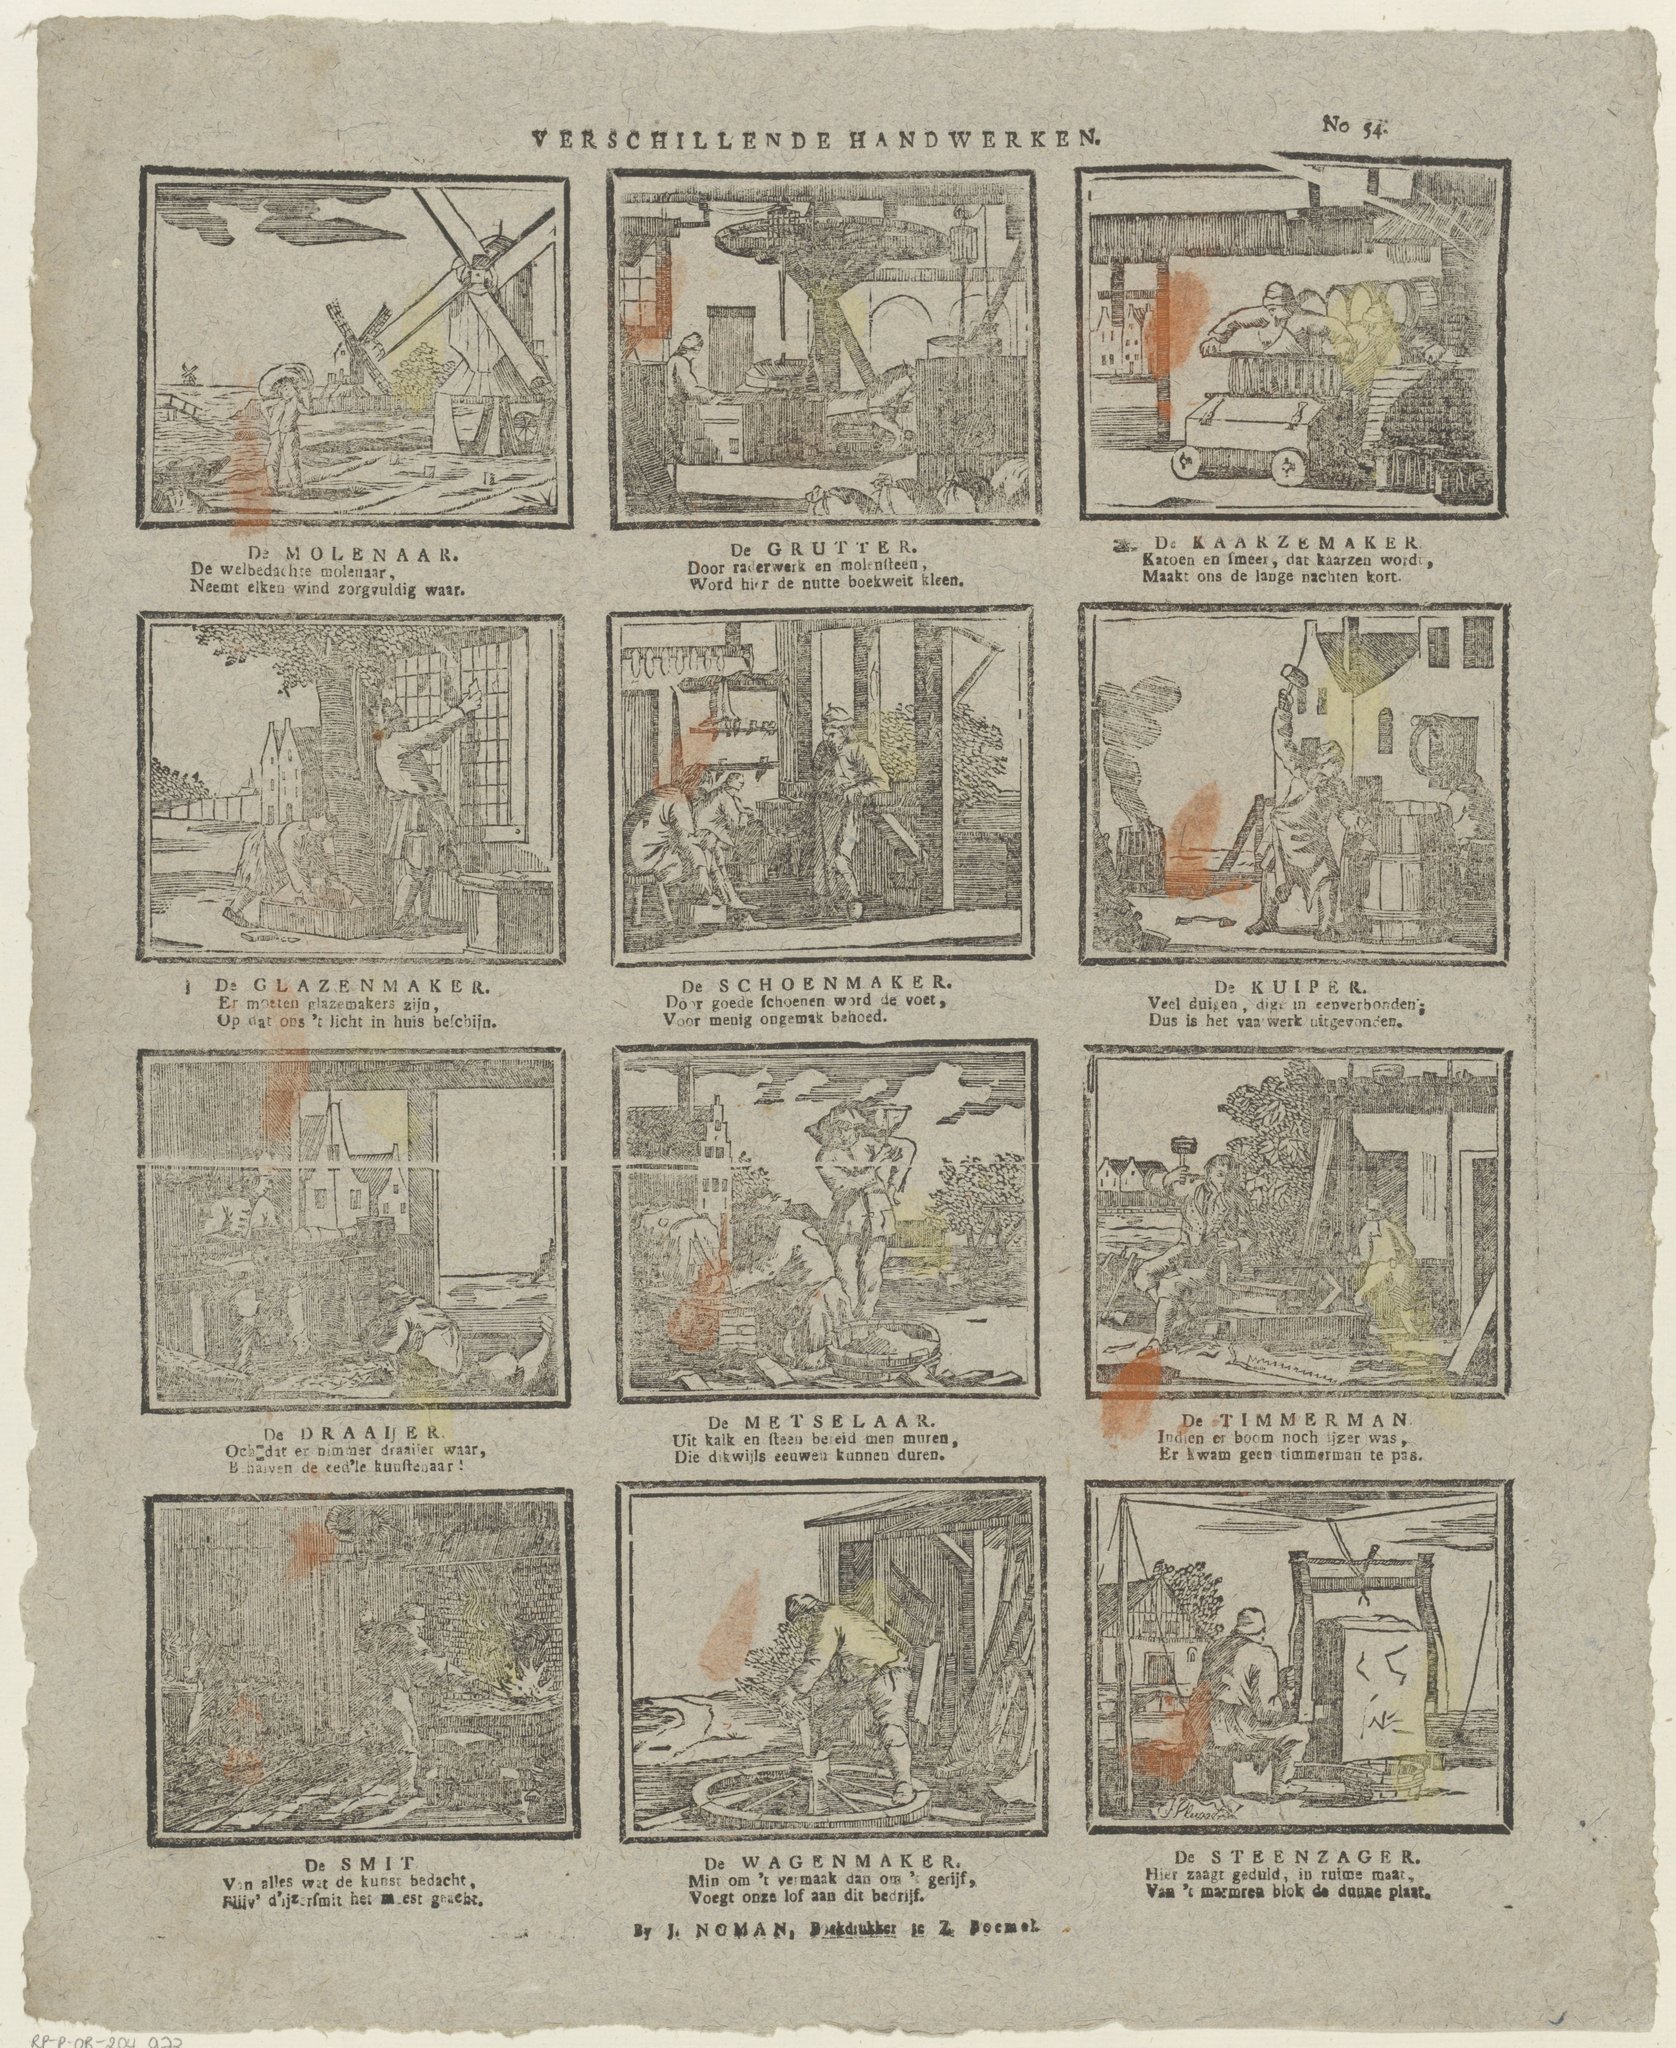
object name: popular print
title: Verschillende handwerken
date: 1806-1830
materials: paper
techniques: colour, letterpress printing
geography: zaltbommel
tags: craft-production, skilled handiwork, miller, working class, labourers, smith, blacksmith, mason at work, crafts and industries, shoe-maker, cobbler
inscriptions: collector's mark: Lugt 2760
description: Blad met 12 voorstellingen van ambachtslieden en beroepen, zoals molenaar, kaarsenmaker en schoenmaker. Onder elke afbeelding een titel en een tweeregelig vers. Genummerd rechtsboven: No 54.